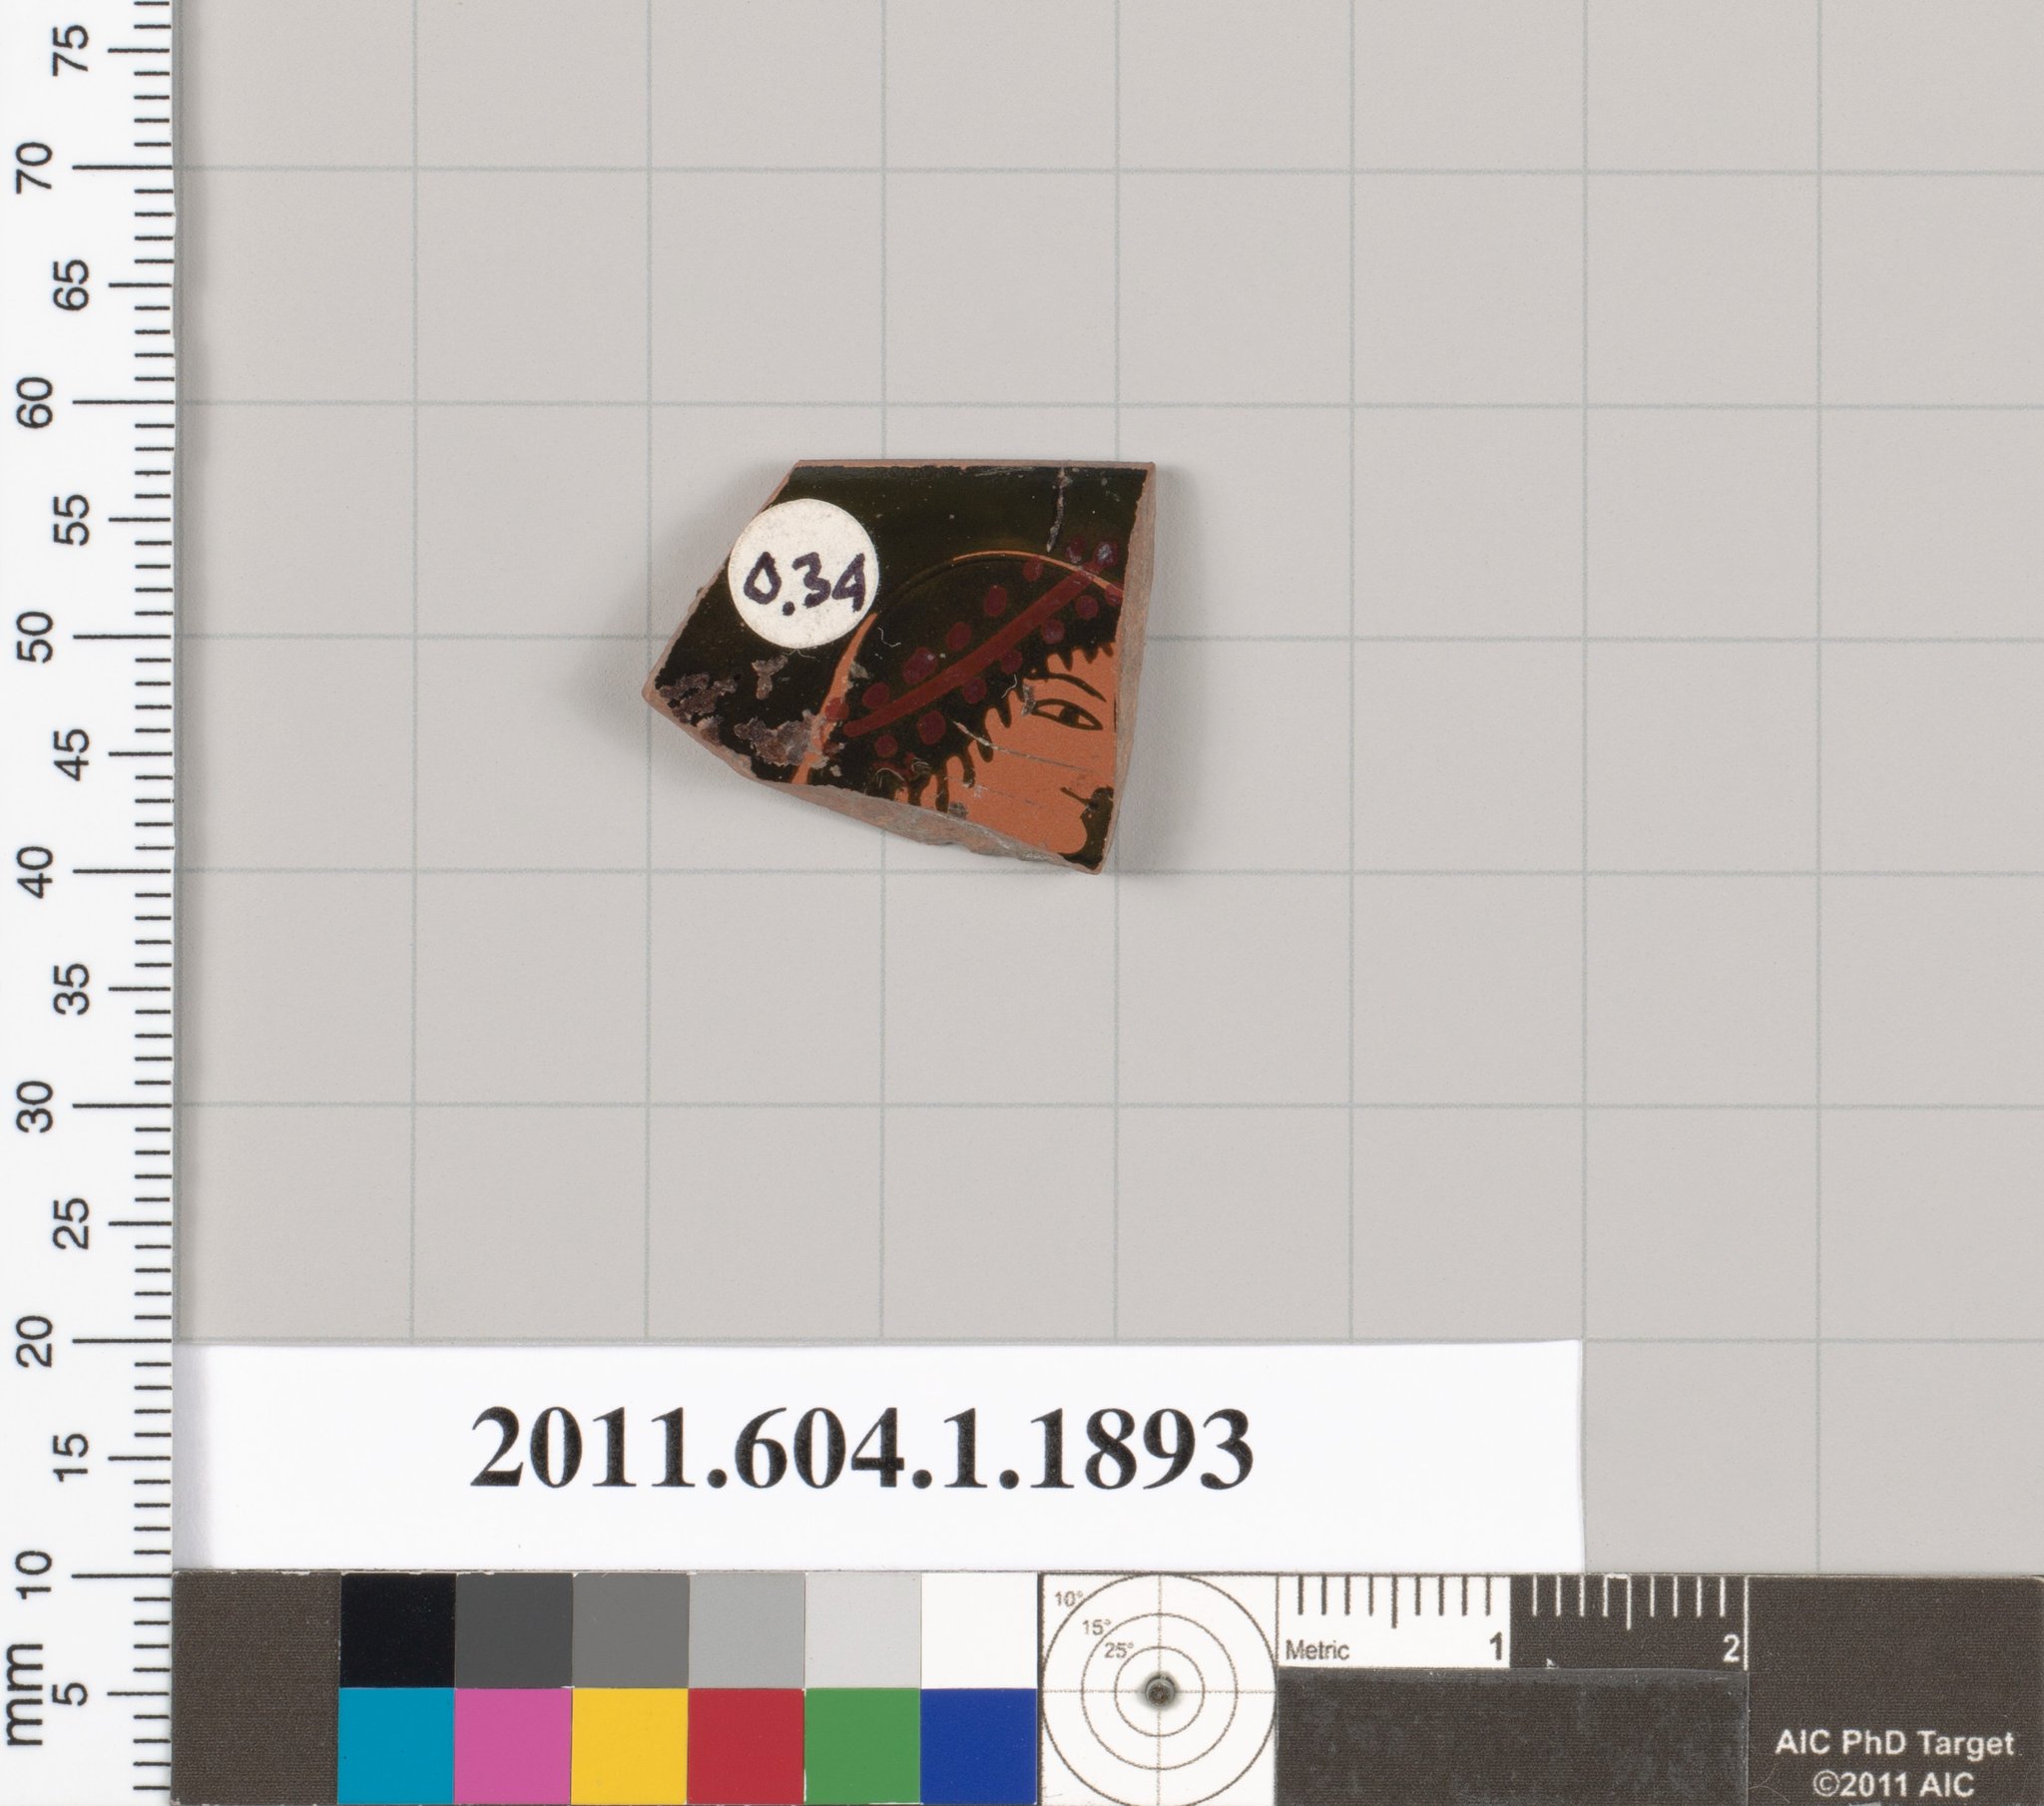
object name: kylix fragment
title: Terracotta rim fragment of a kylix (drinking cup)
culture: greek, attic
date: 520-510 BCE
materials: terracotta